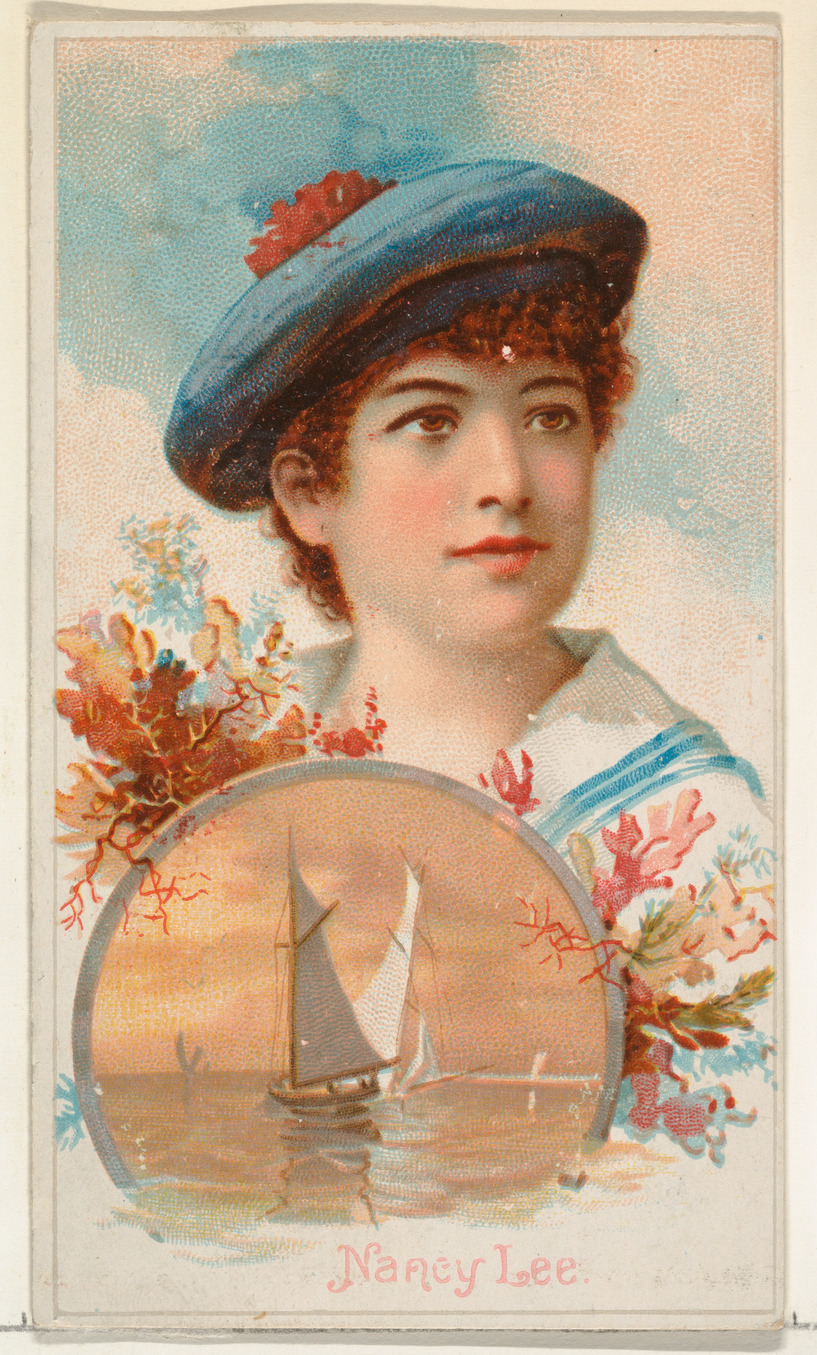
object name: print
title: Nancy Lee, from the Illustrated Songs series (N116) issued by W. Duke, Sons & Co. to promote Honest Long Cut Tobacco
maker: w. duke, sons & co.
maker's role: publisher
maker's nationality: american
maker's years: 1870-1920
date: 1893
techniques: color lithograph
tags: women,boats